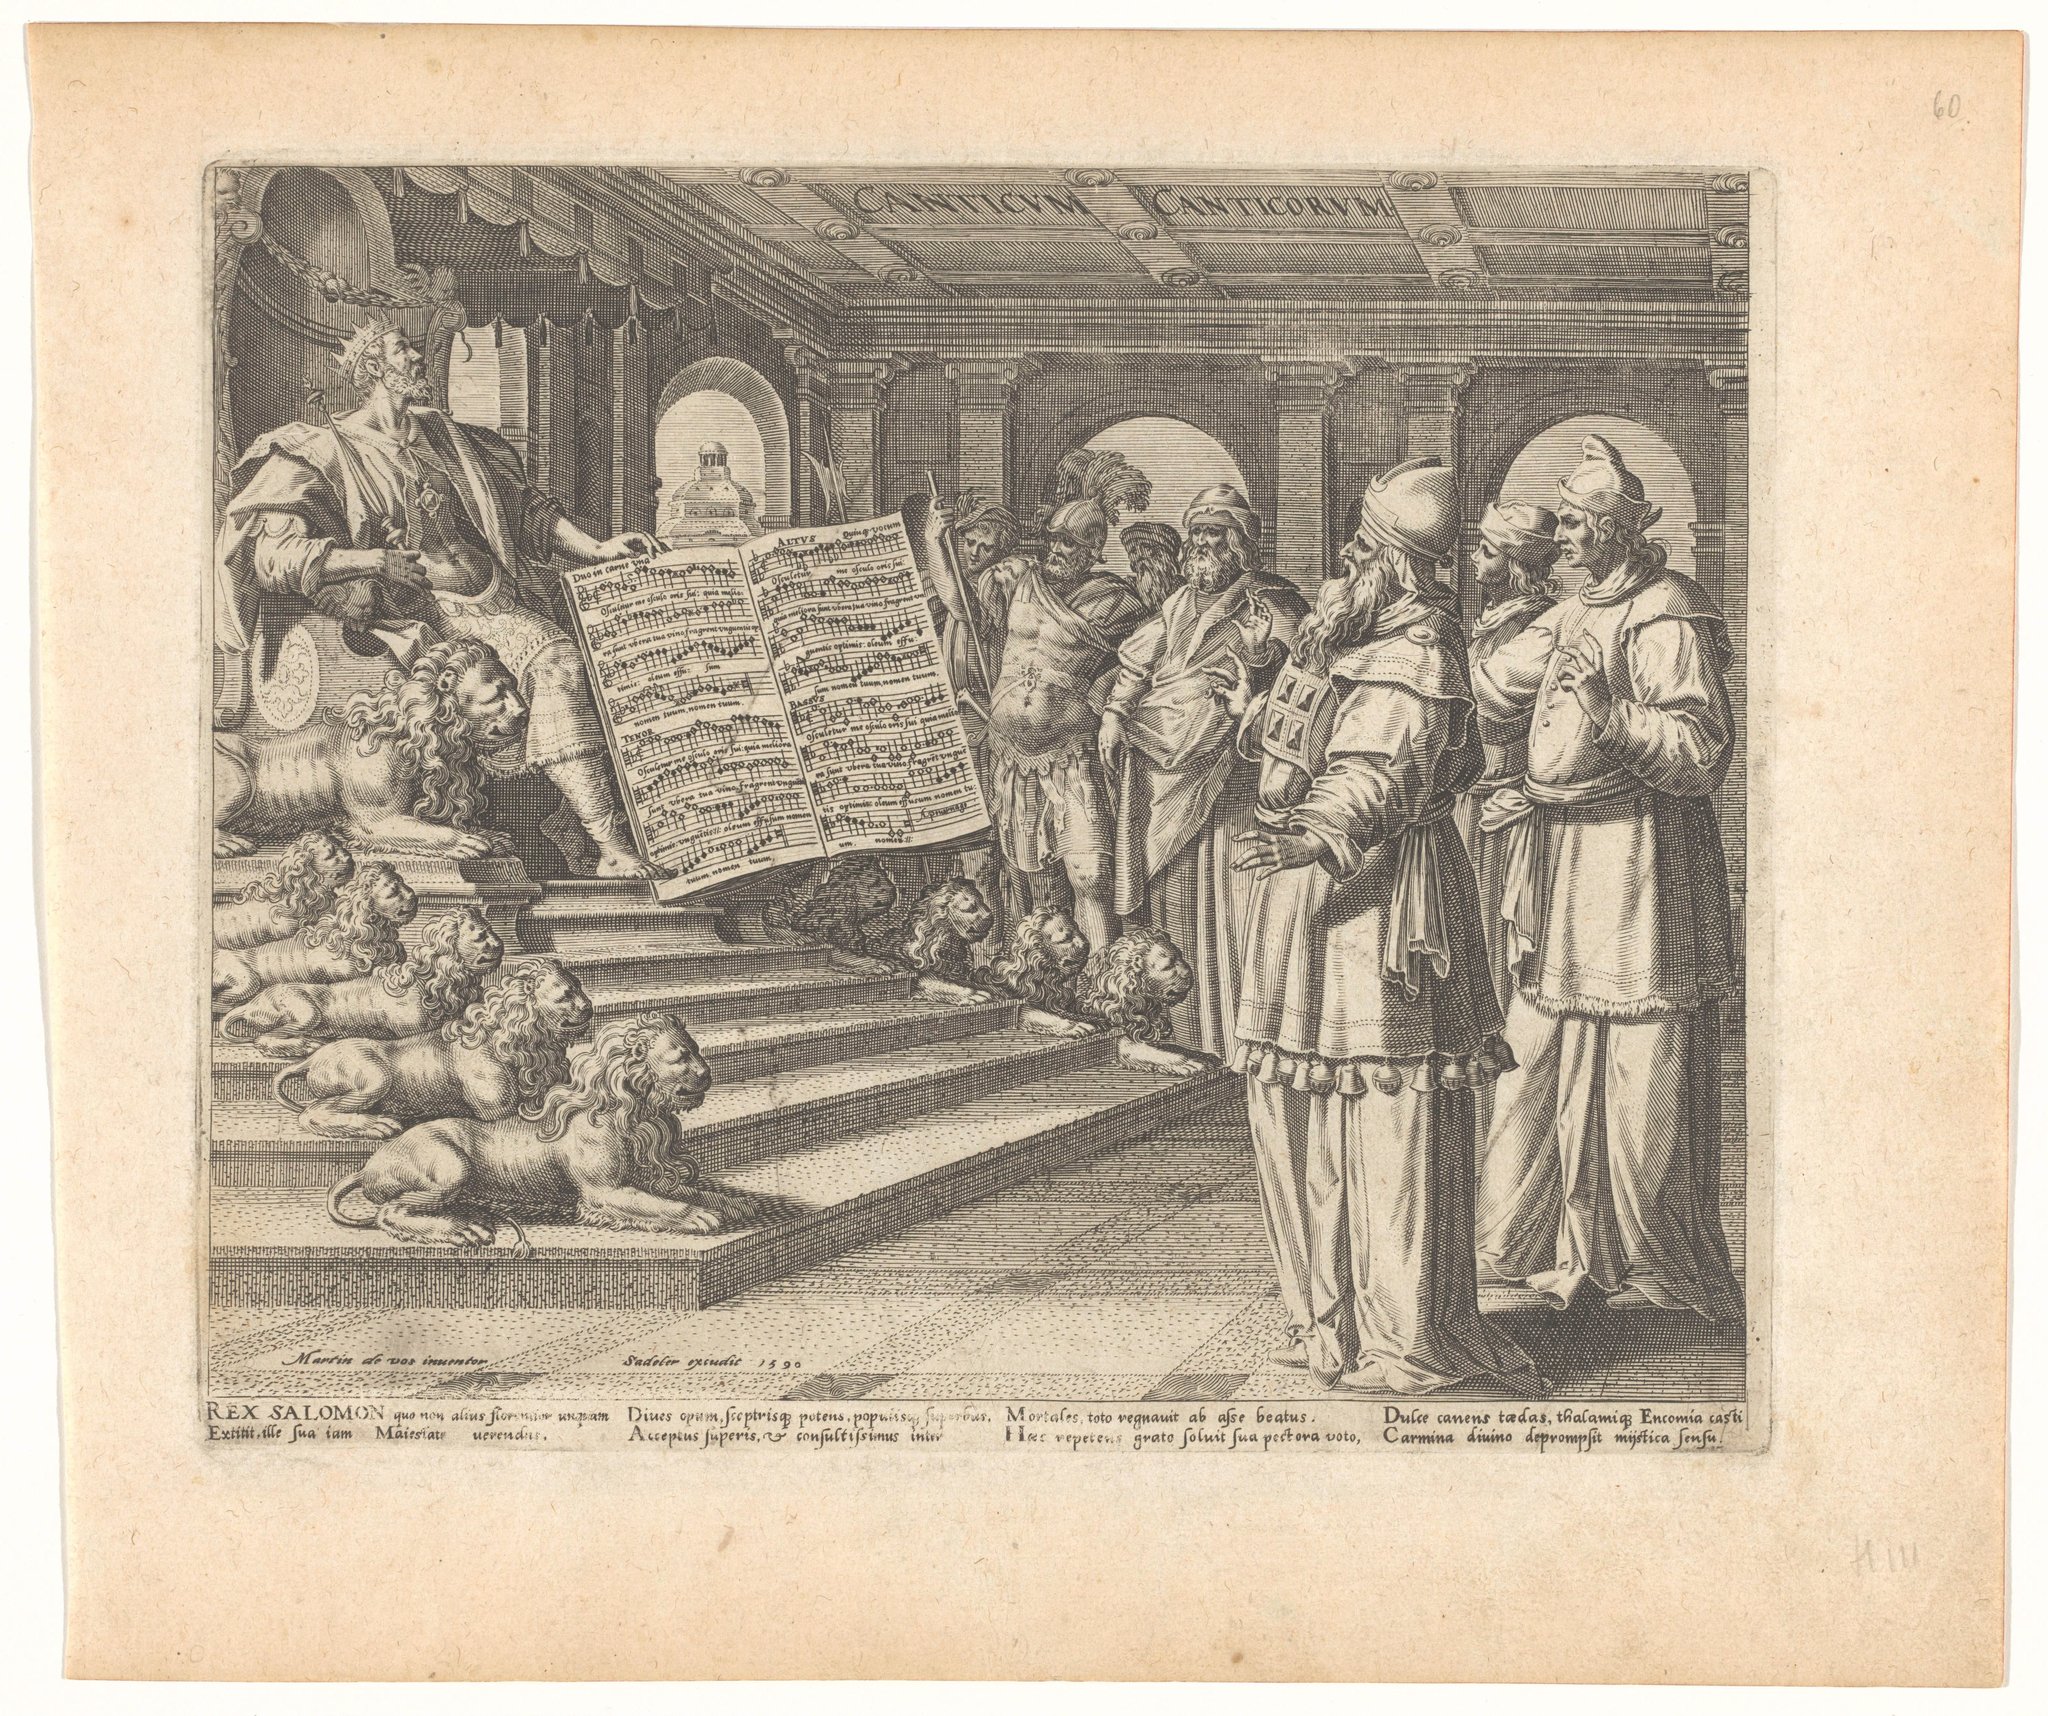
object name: print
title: Hooglied van Salomo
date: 1590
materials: paper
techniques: engraving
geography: southern netherlands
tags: twelve lions on the steps of the throne of solomon, solomon and his court, printed edition of musical score, song of solomon, song of songs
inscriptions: collector's mark: Lugt 2228, collector's mark: Lugt 2760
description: Titelblad van een serie van zes gewijd aan het Hooglied. Salomo, gezeten op zijn troon en omringd door priesters en hovelingen, toont de partituur van een motet van de Vlaamse componist Andreas Pévernage. Boven hem, tegen de zoldering het opschrift: Canticum Canticorum.